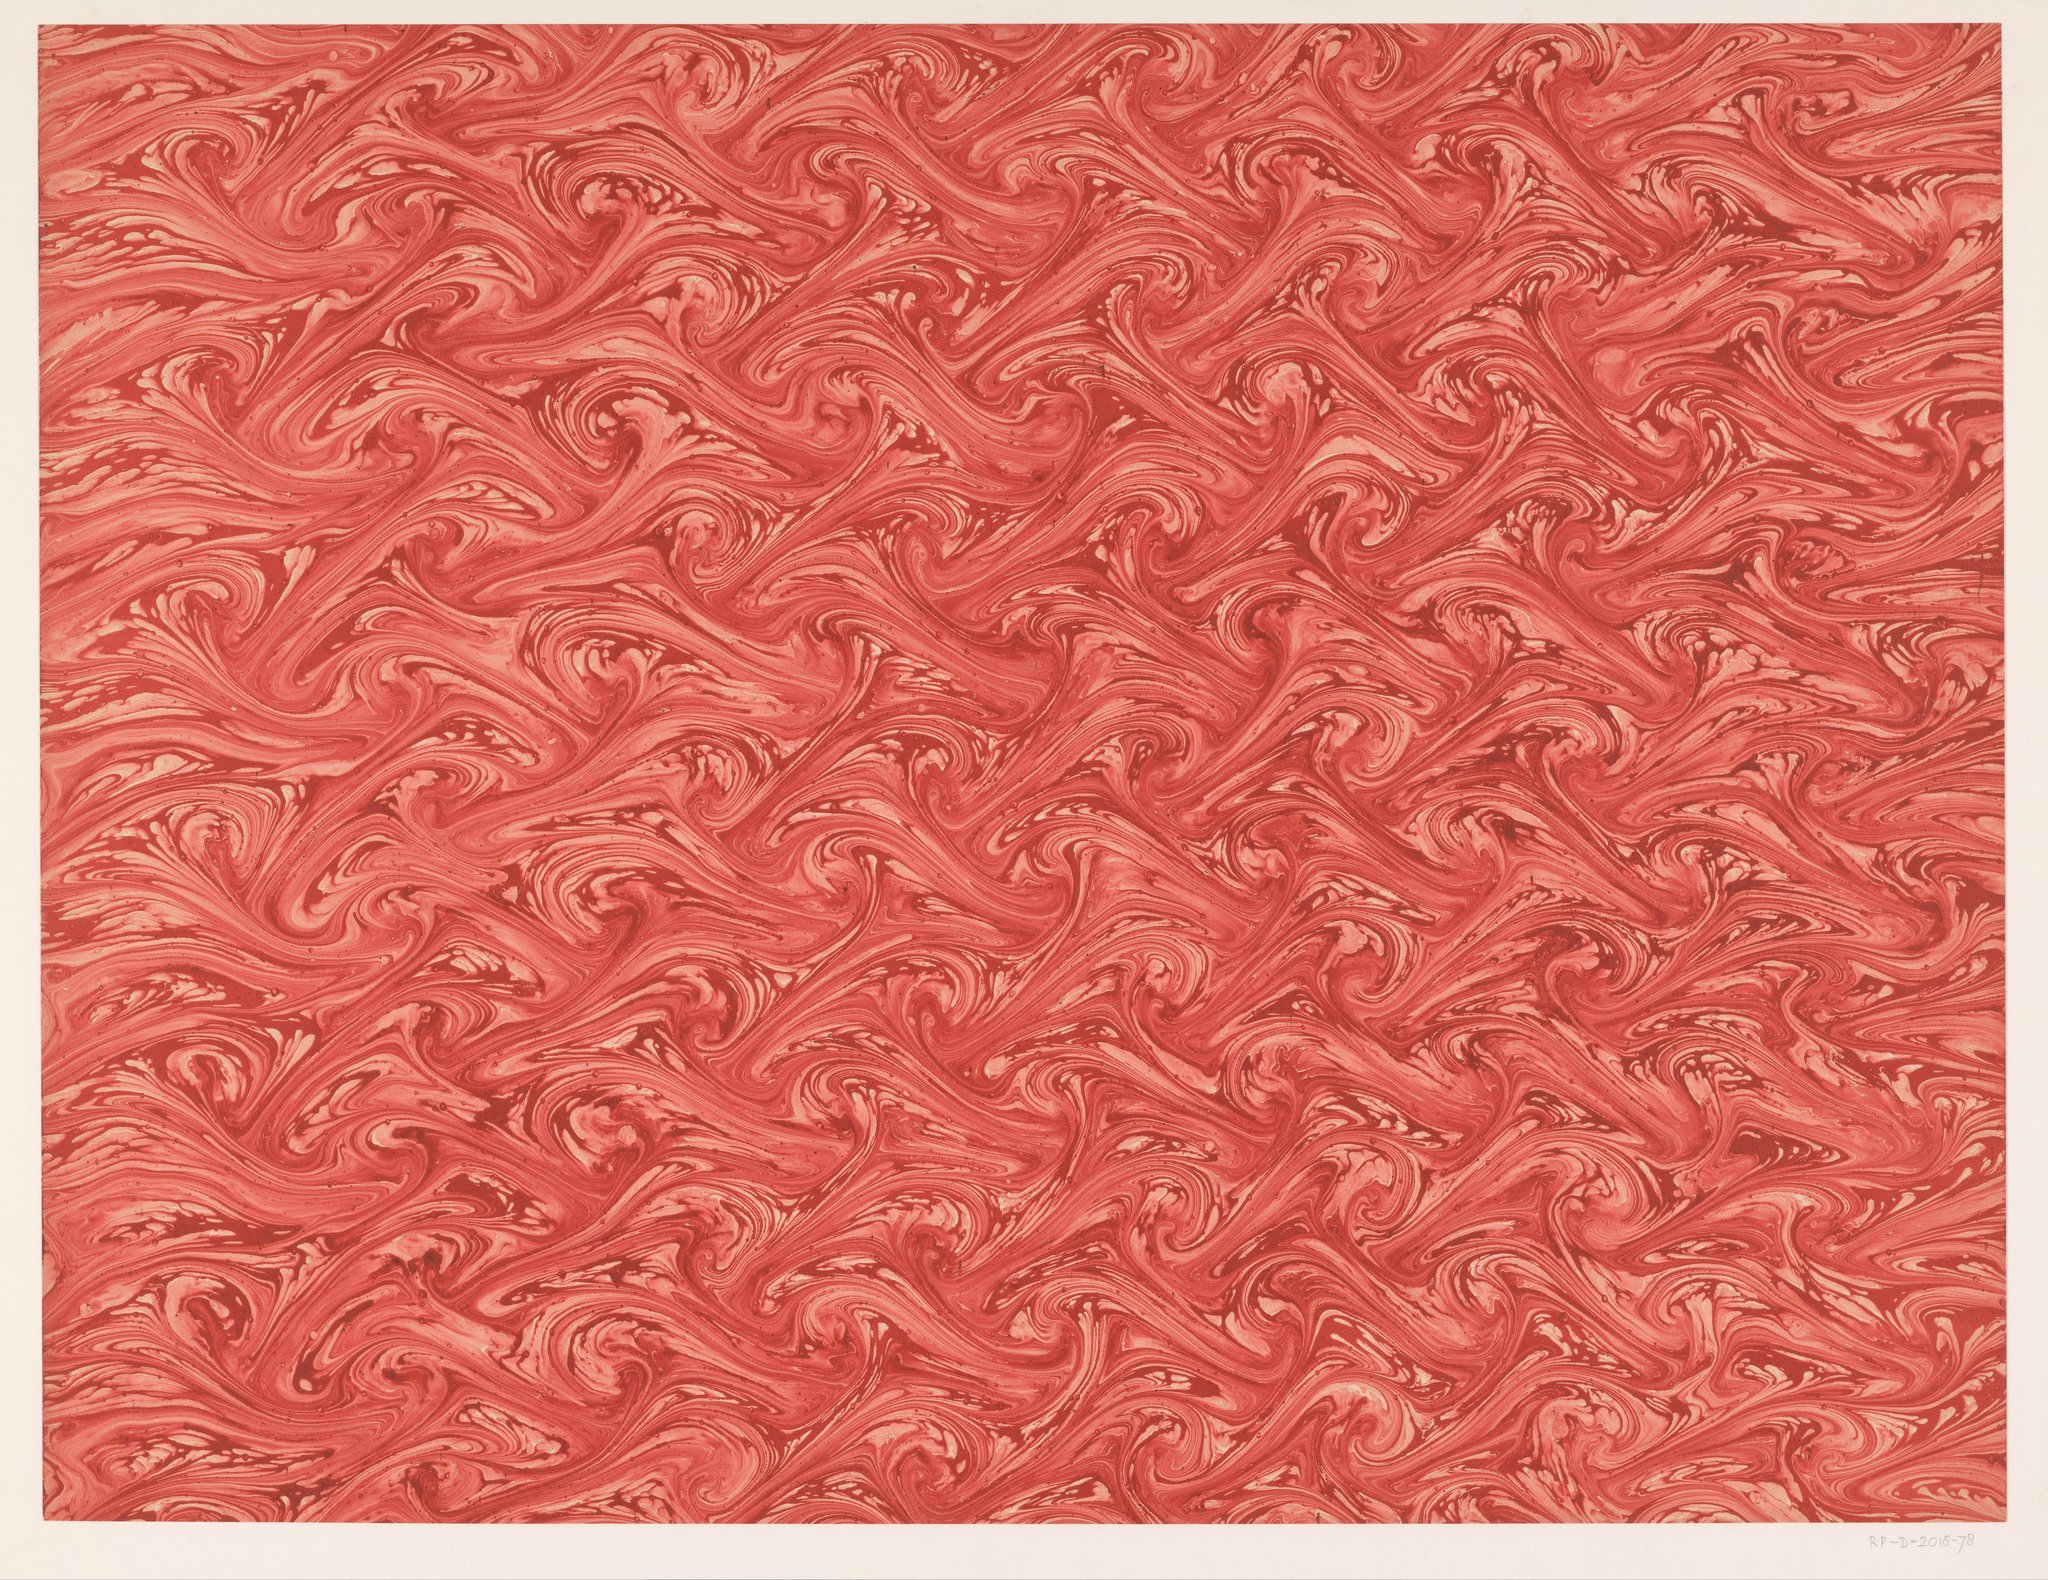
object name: marbled paper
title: Fantasiemarmer in verschillende tinten rood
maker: Anonymous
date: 1900-2000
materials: paint, paper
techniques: marbled paper